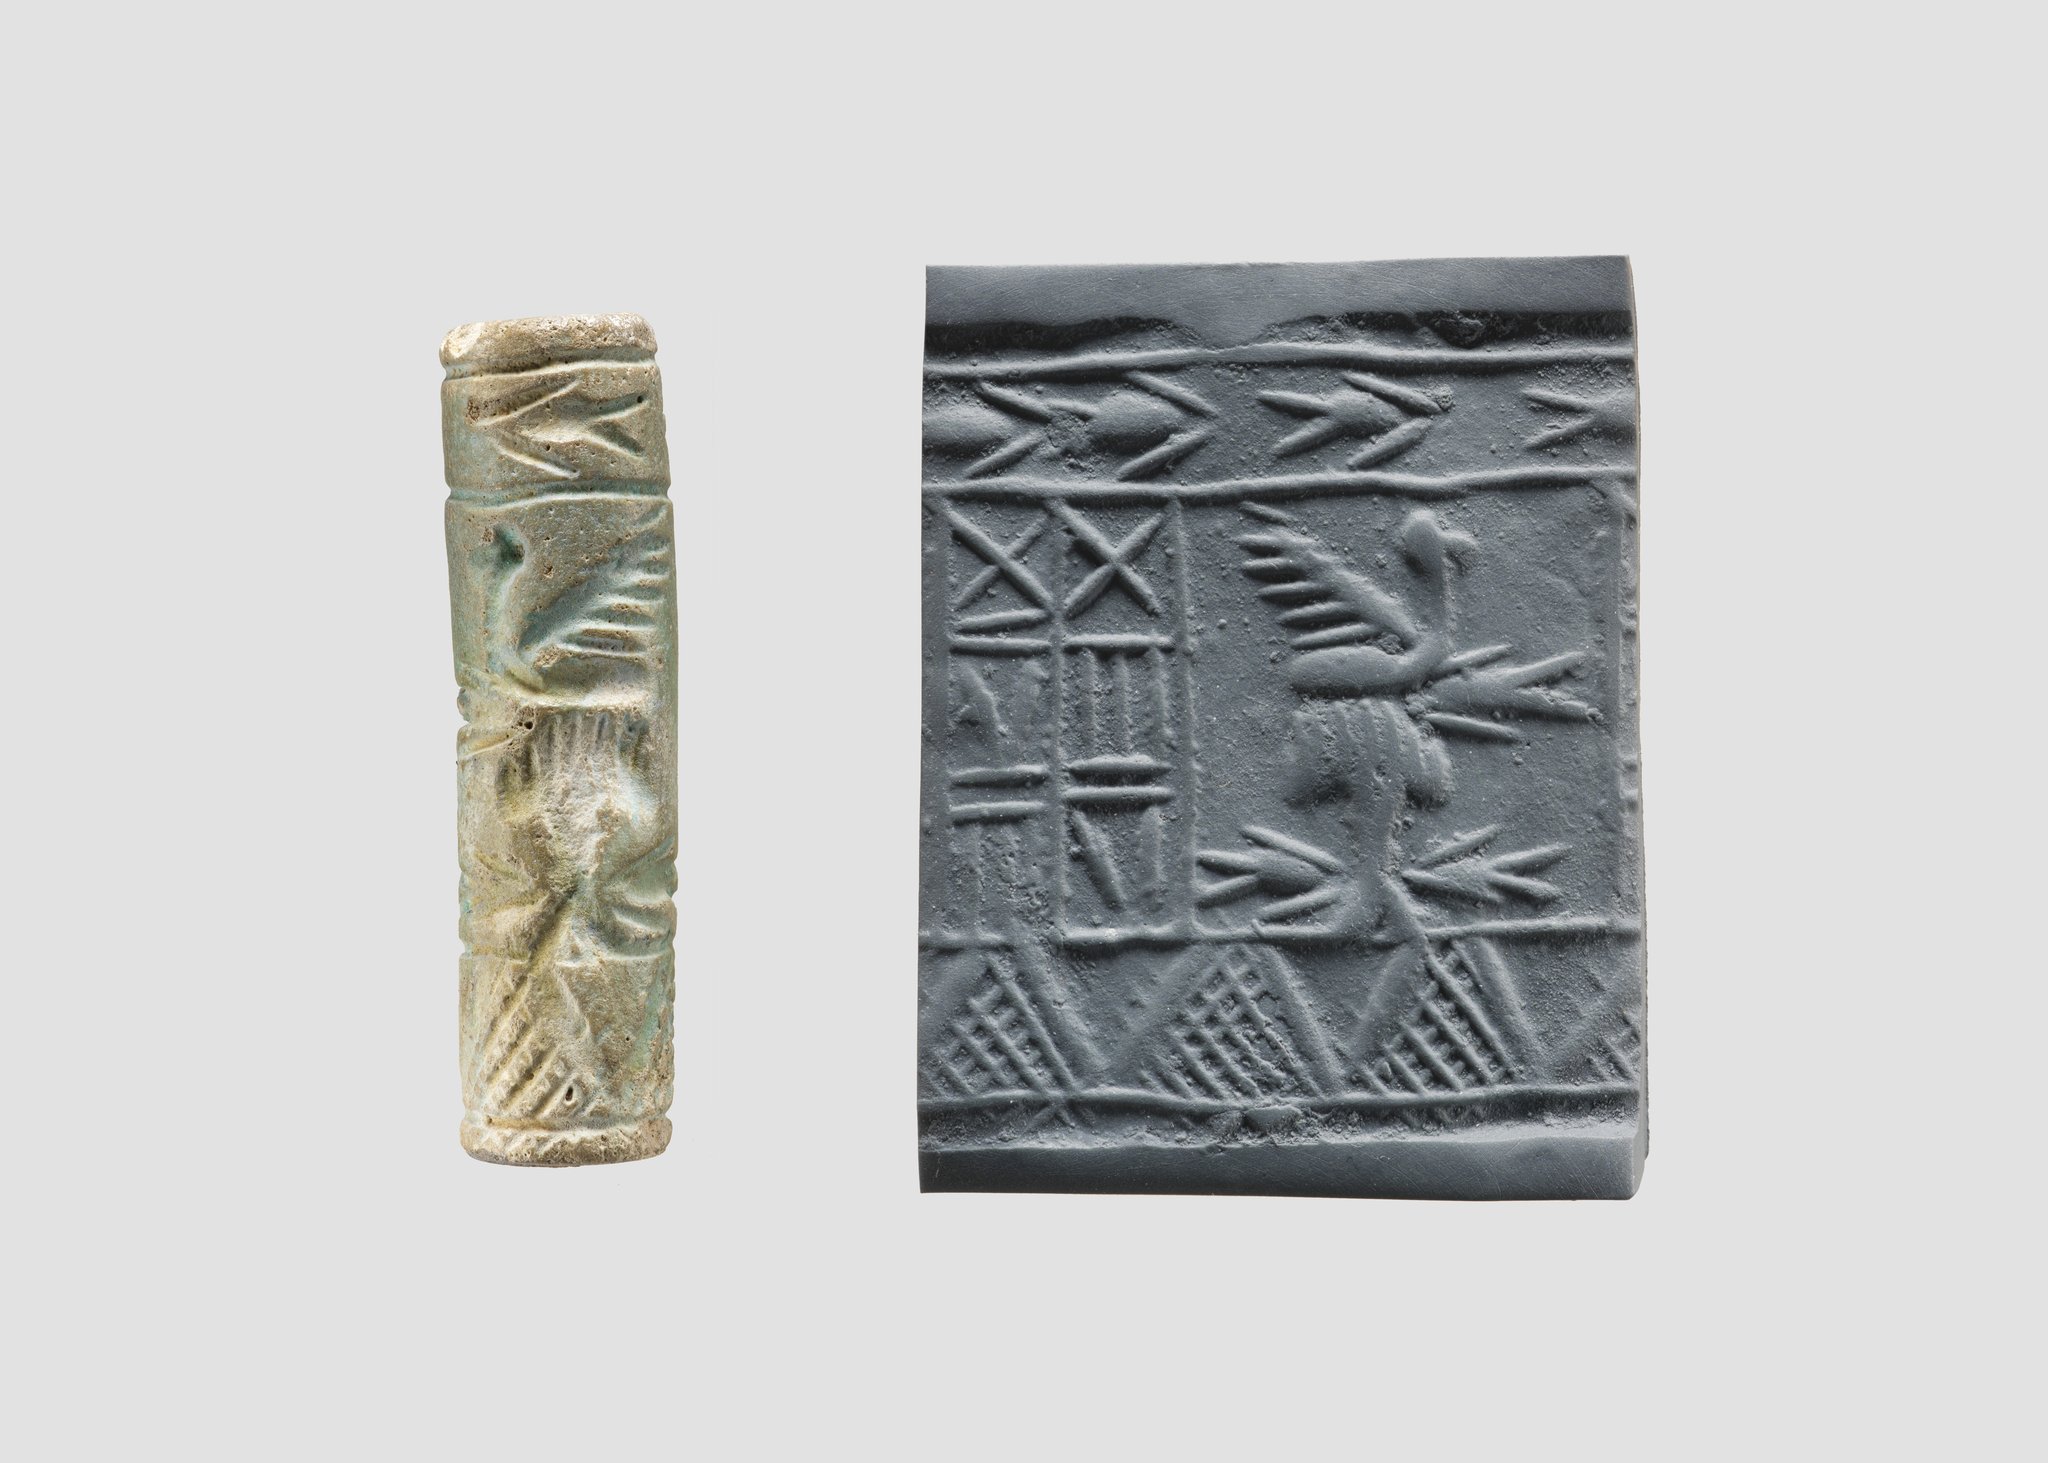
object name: cylinder seal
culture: iranian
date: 1250-1050 BCE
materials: ceramic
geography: iran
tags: birds